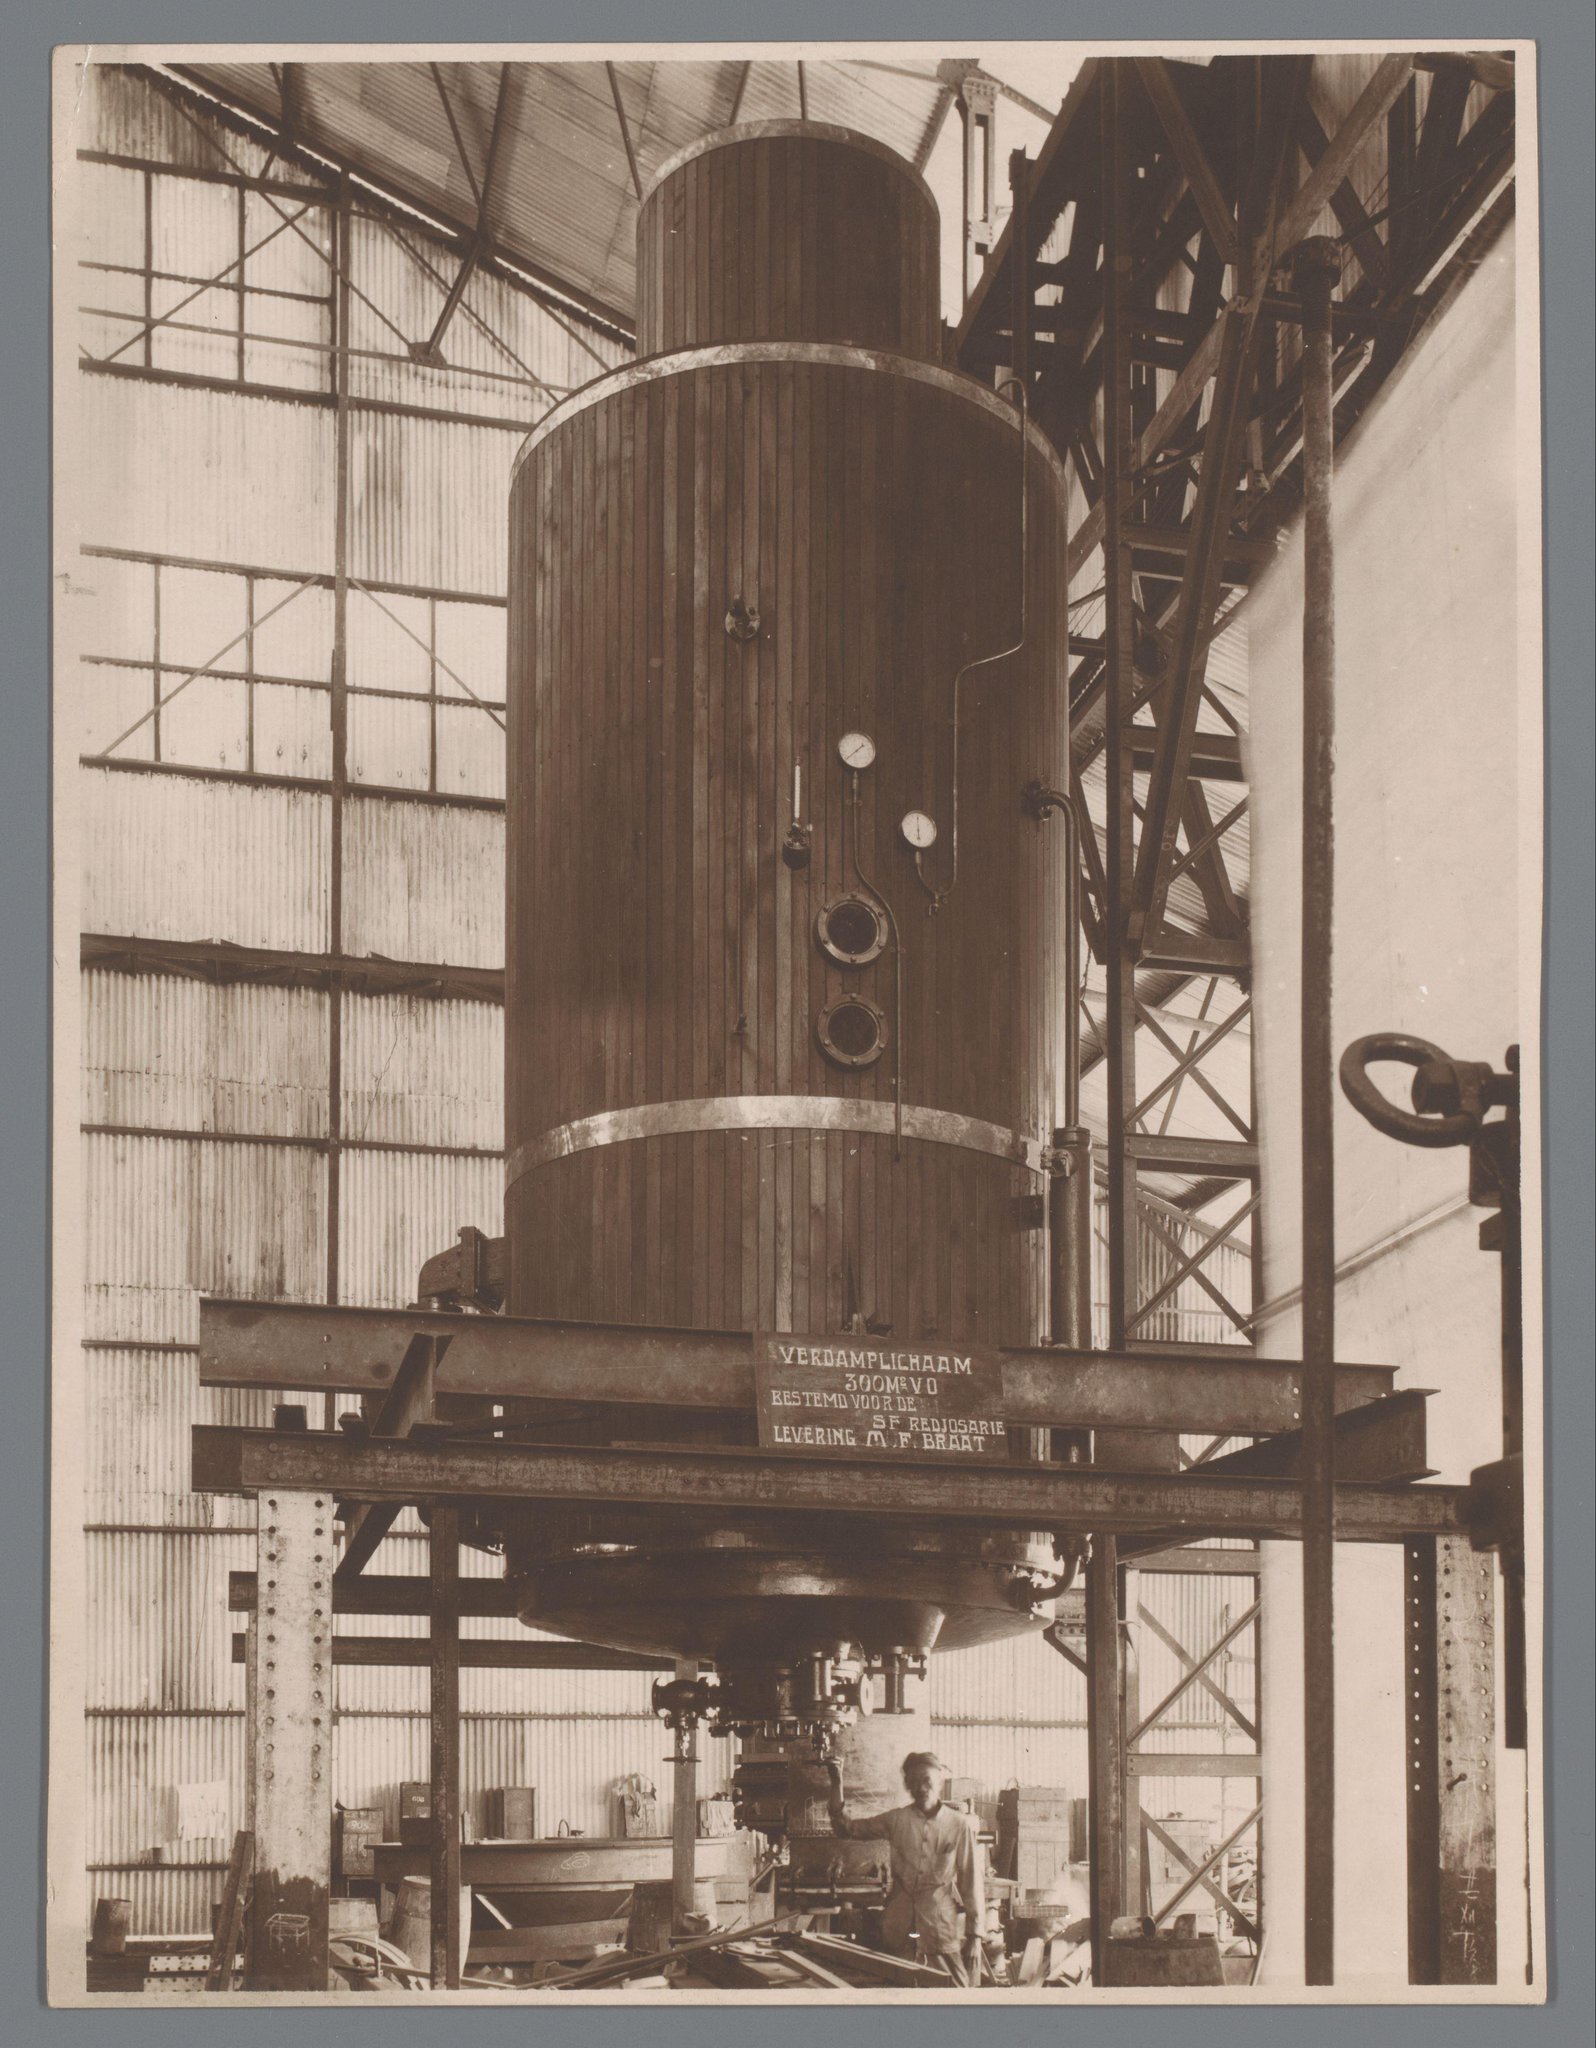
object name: photograph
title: Verdamplichaam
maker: Anonymous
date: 1917-1938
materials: photographic support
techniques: gelatin silver print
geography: surabaya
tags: colonial system, factory-interior, machine shop, machines; parts of machines; tools and appliances, (non-fruit) products of plants or trees: sugarcane, java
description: Verdamplichaam bestemd voor de Suikerfabriek Redjosari in de Lampongsche Districten. Onderdeel van de multomap met foto's van machines van de N.V. Machinefabriek Braat te Soerabaja bestemd voor de Nederlandse suikerindustrie op Java, uit de periode 1917-1938.